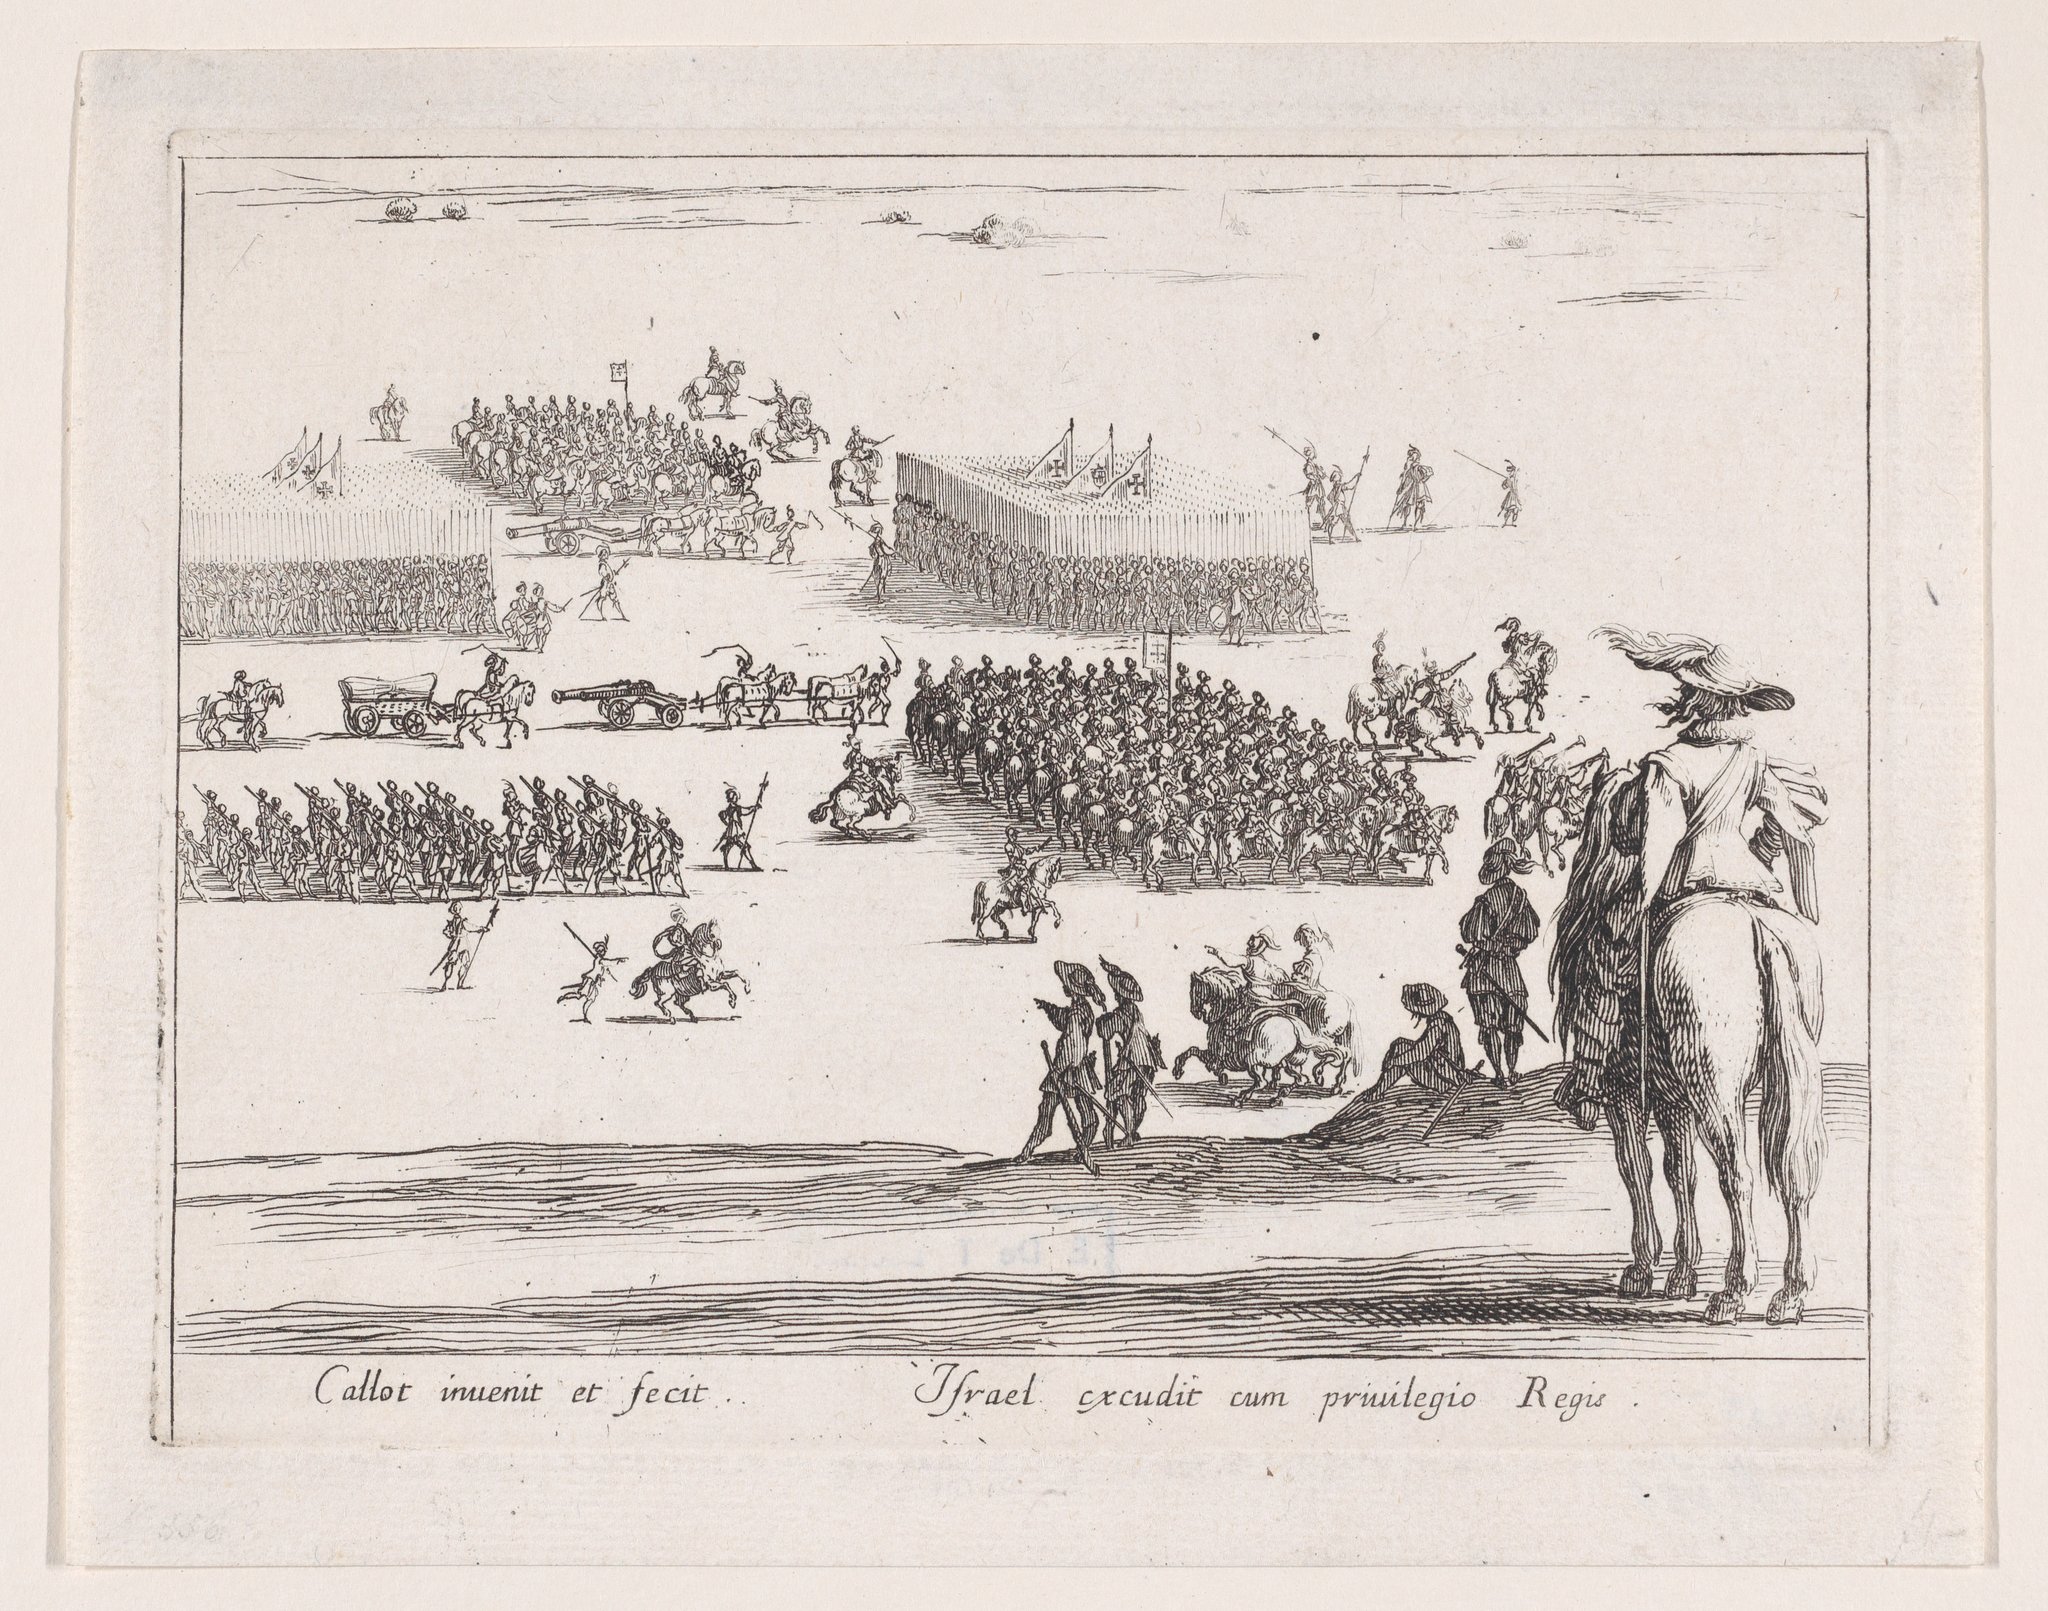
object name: print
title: La Revue (The Review)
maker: jacques callot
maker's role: artist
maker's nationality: french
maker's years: 1592-1635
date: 1628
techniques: etching